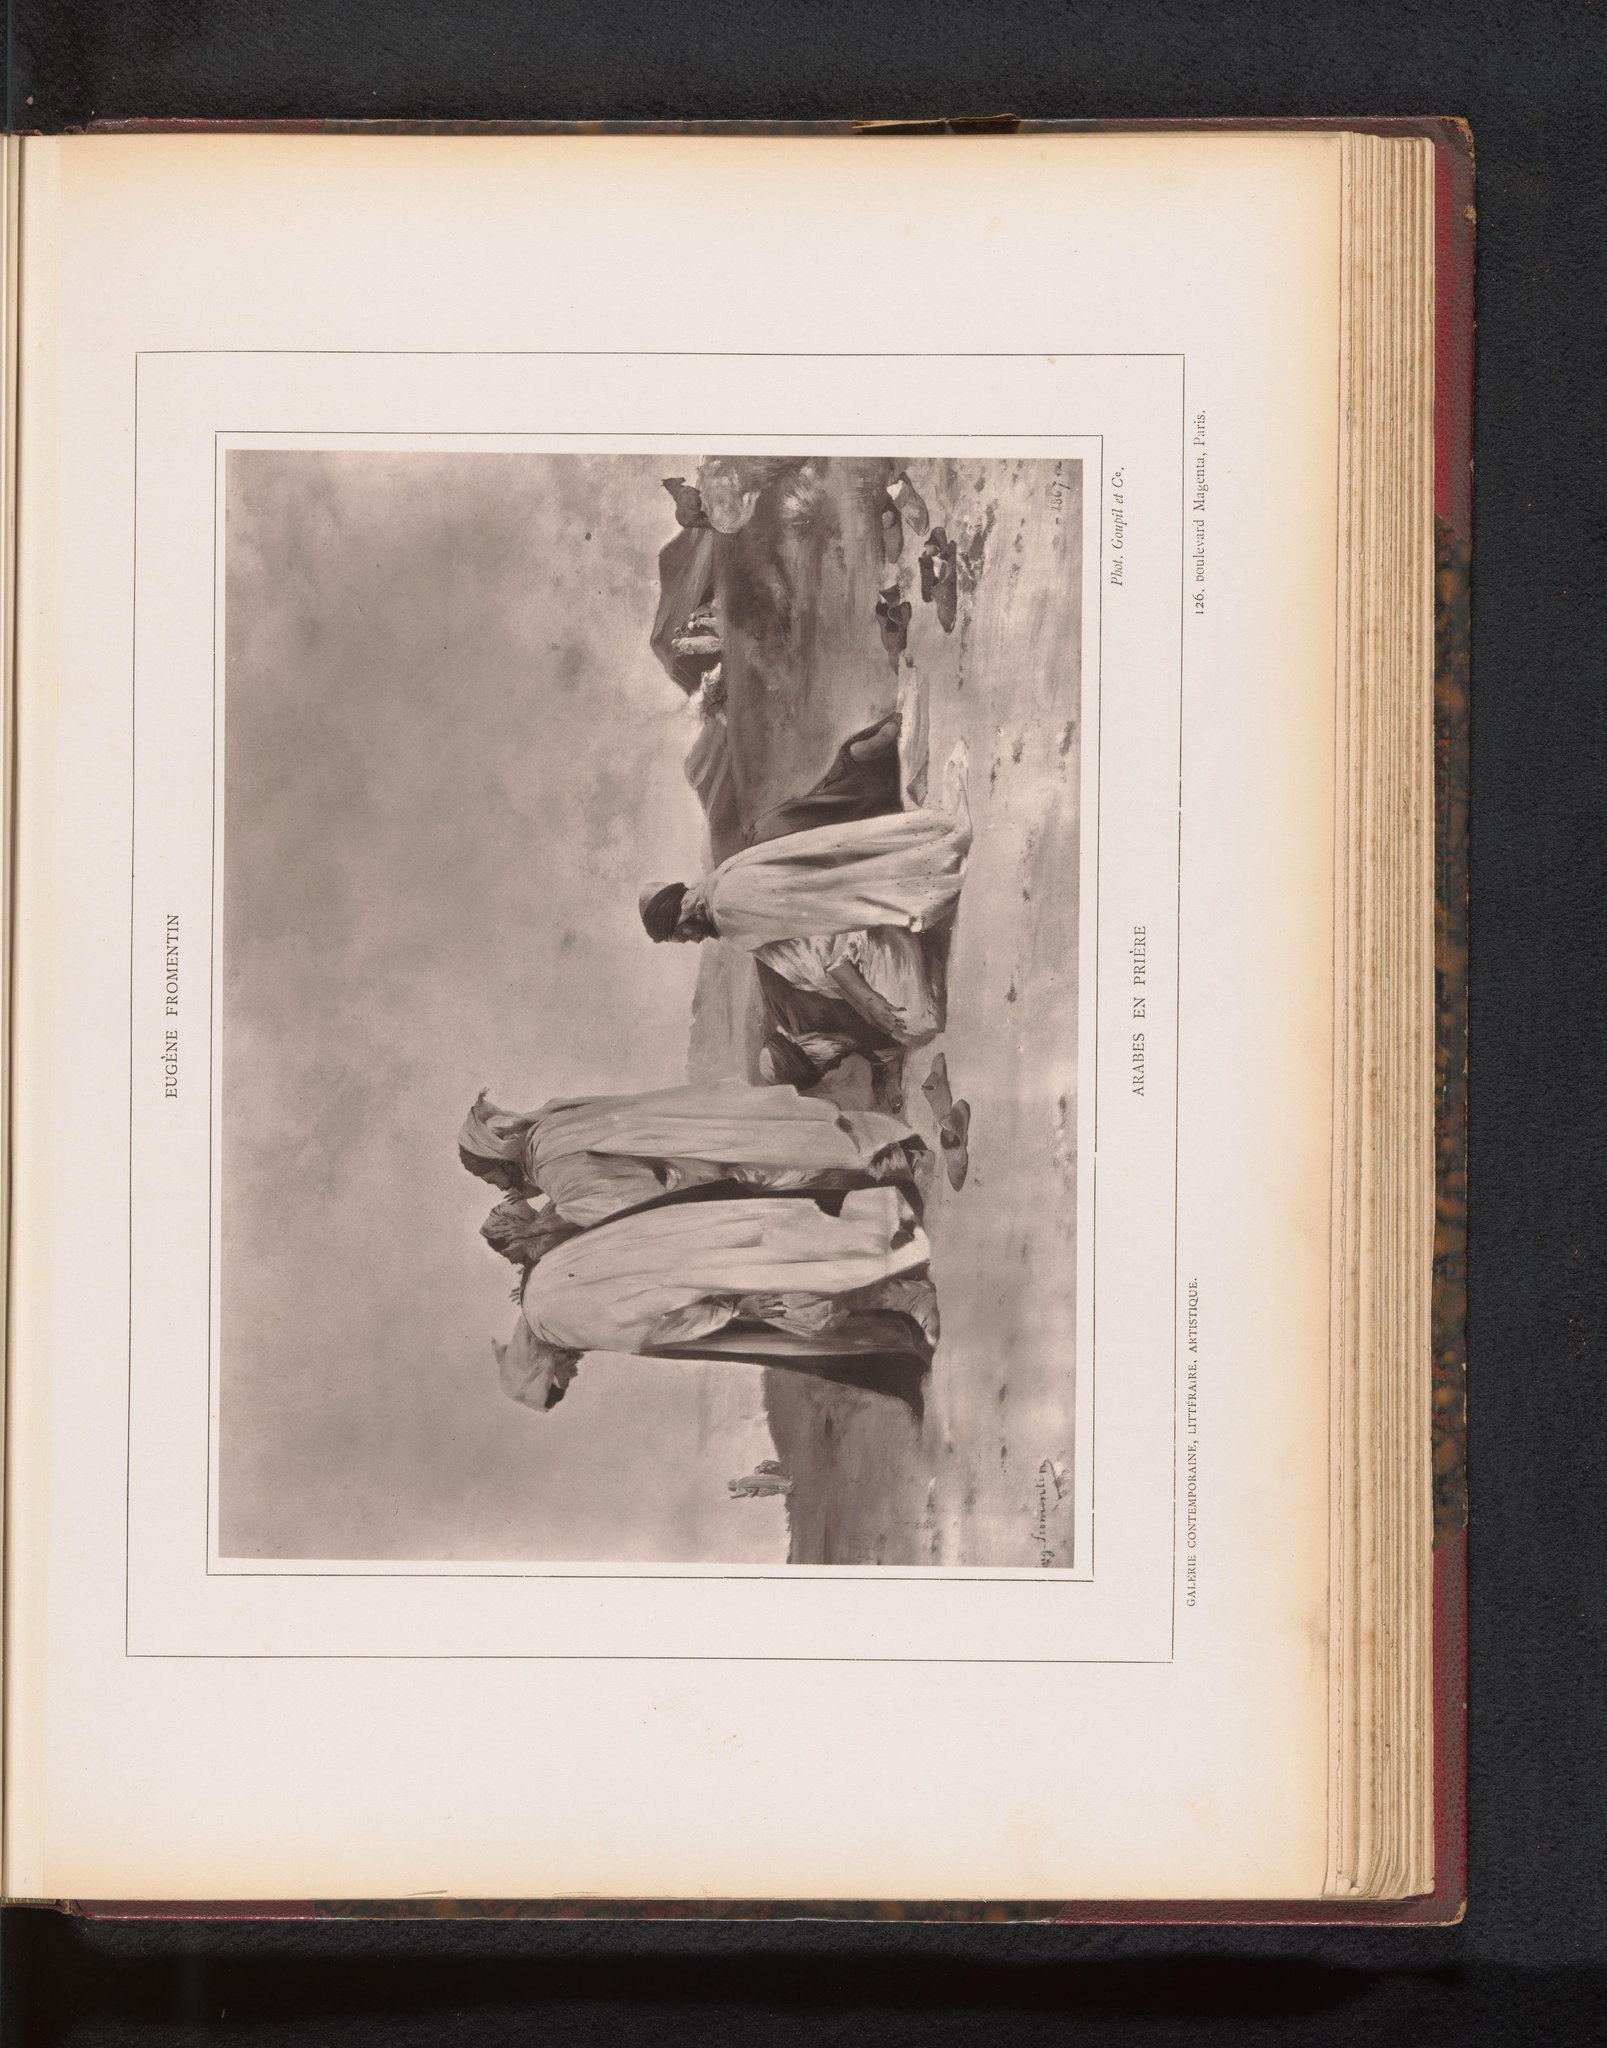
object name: page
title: Reproductie van Arabes en prière door Eugène Fromentin-Dupeux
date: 1871-1876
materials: paper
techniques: woodburytype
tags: ritual objects and ritual means ~ non-christian religions, painting, drawing and the graphic arts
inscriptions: inscription: ‘Eugène Fromentin/ Galerie Contemporaine, Littéraire et Artistique/ 126, boulevard Magenta, Paris.’